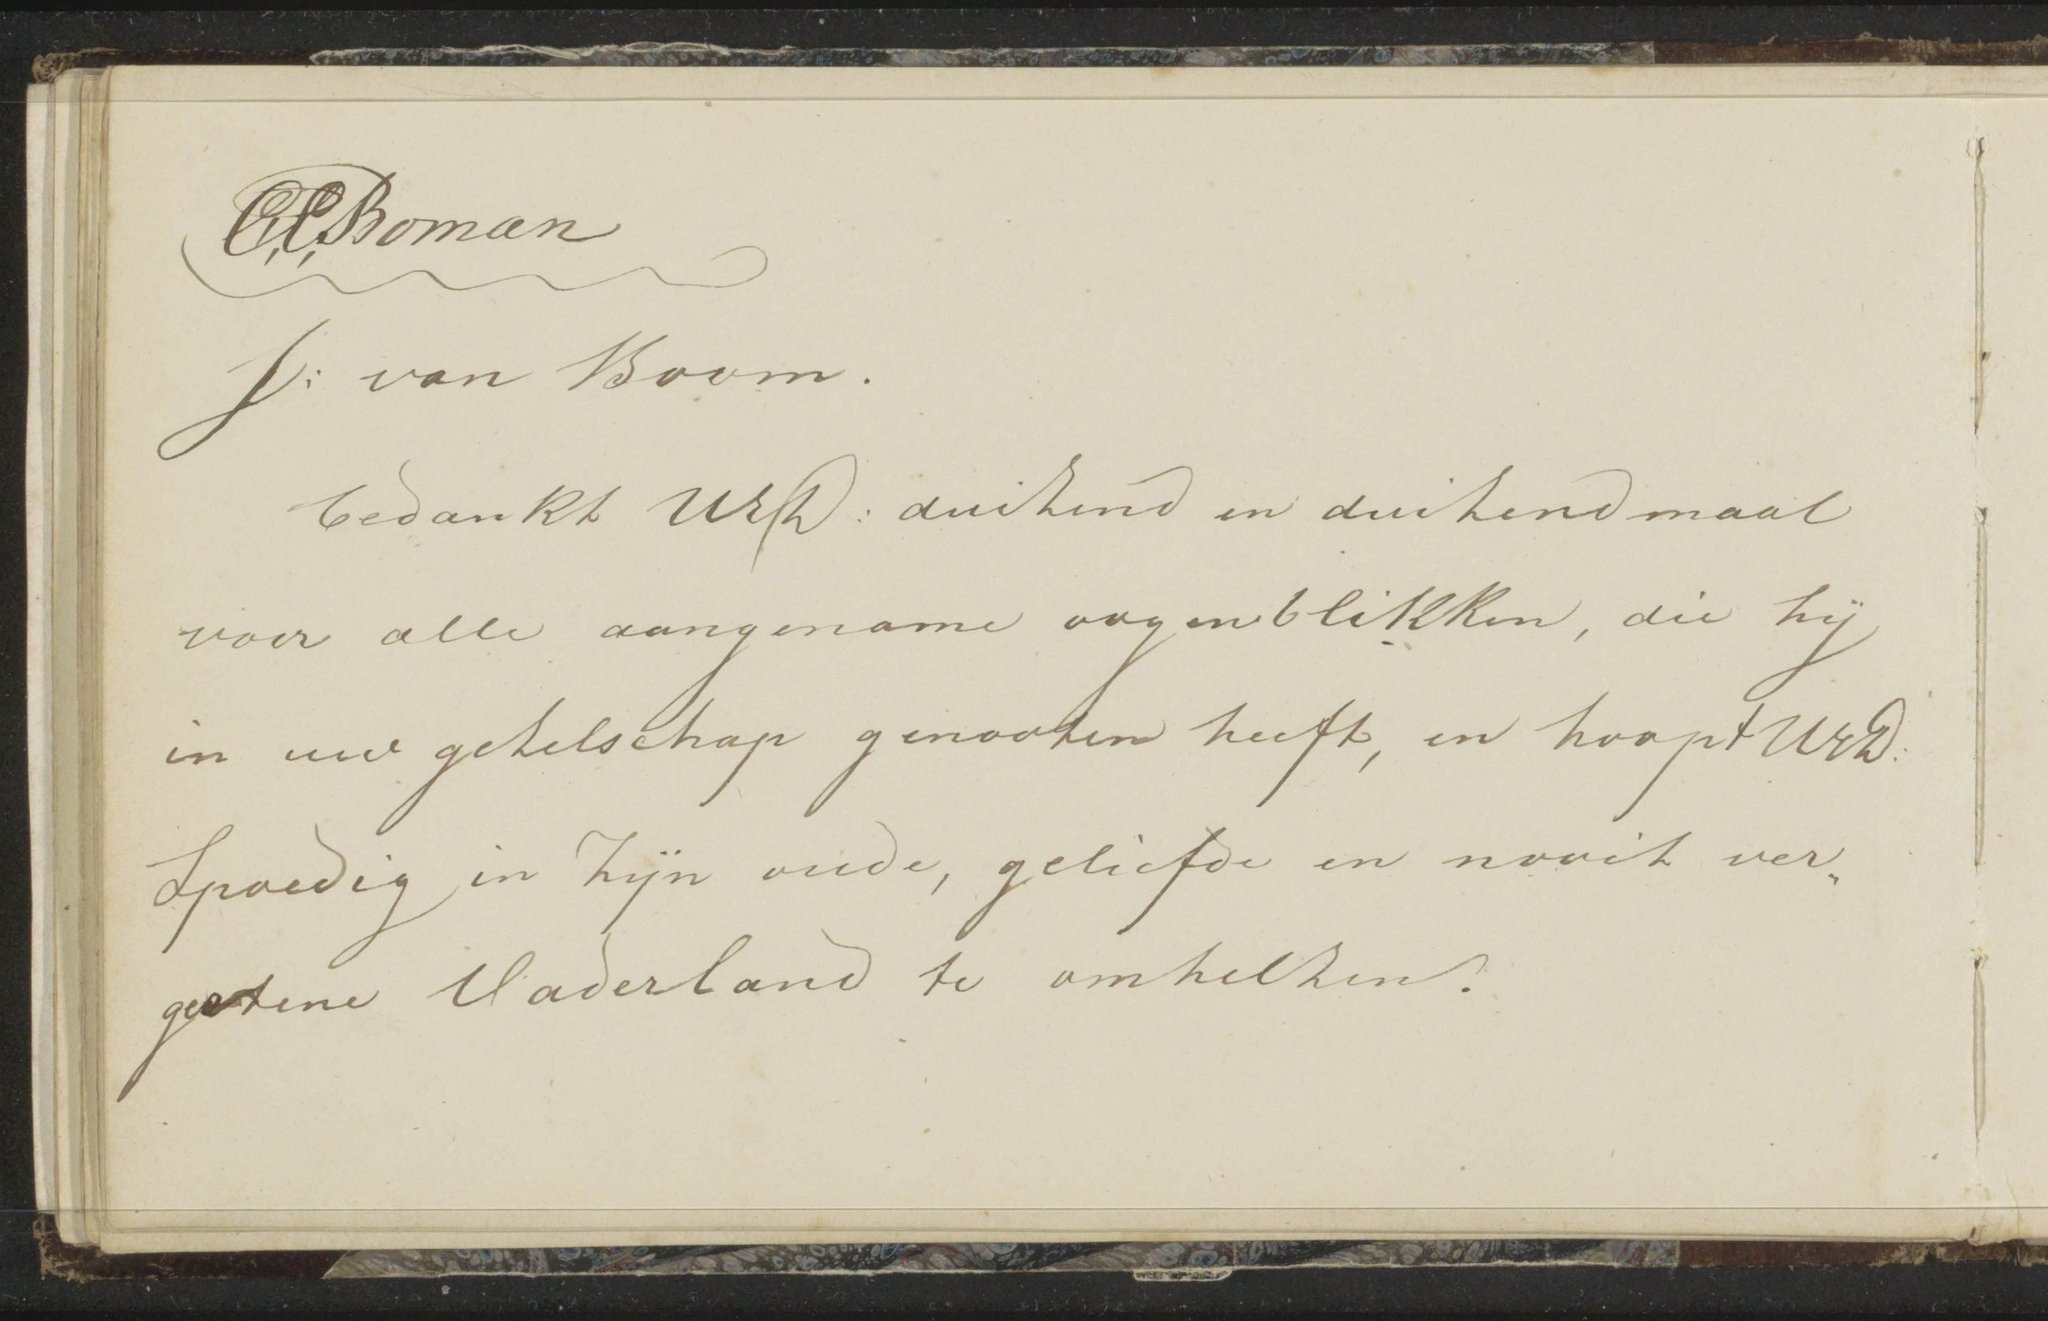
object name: sketchbook leaf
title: Bedankbrief van J. van Boom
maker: christian heinrich gottlieb steuerwald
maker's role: draughtsman, print maker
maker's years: 1802-1874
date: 1845-1848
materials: ink, paper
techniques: pen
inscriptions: annotation: ‘C.C. Boman/ J. Van Boom/ bedankt ... Vaderland te omhelzen.’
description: Blad 19 verso uit een schetsboek met 61 bladen.